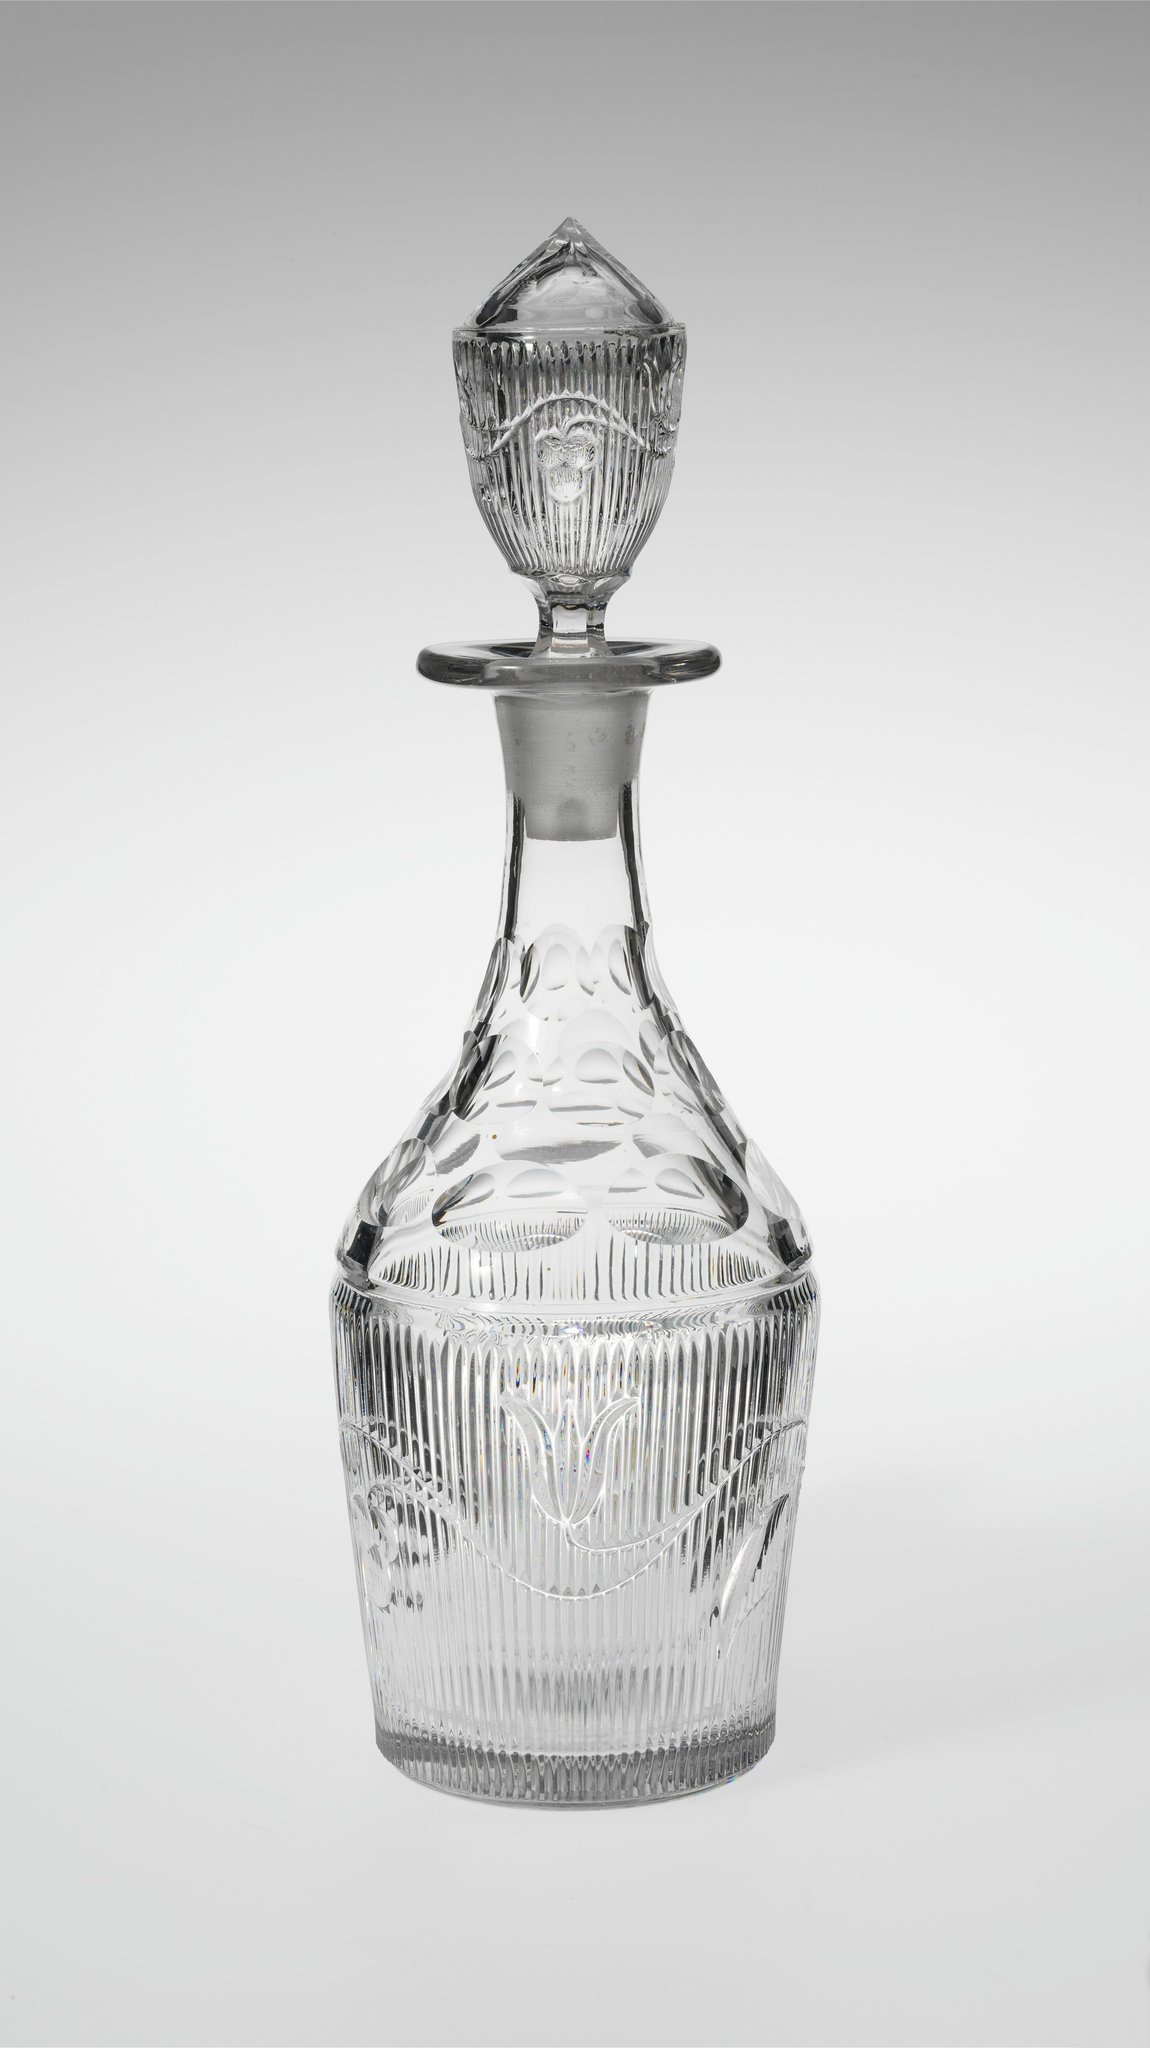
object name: decanter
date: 1850-1870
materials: glass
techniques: pressed